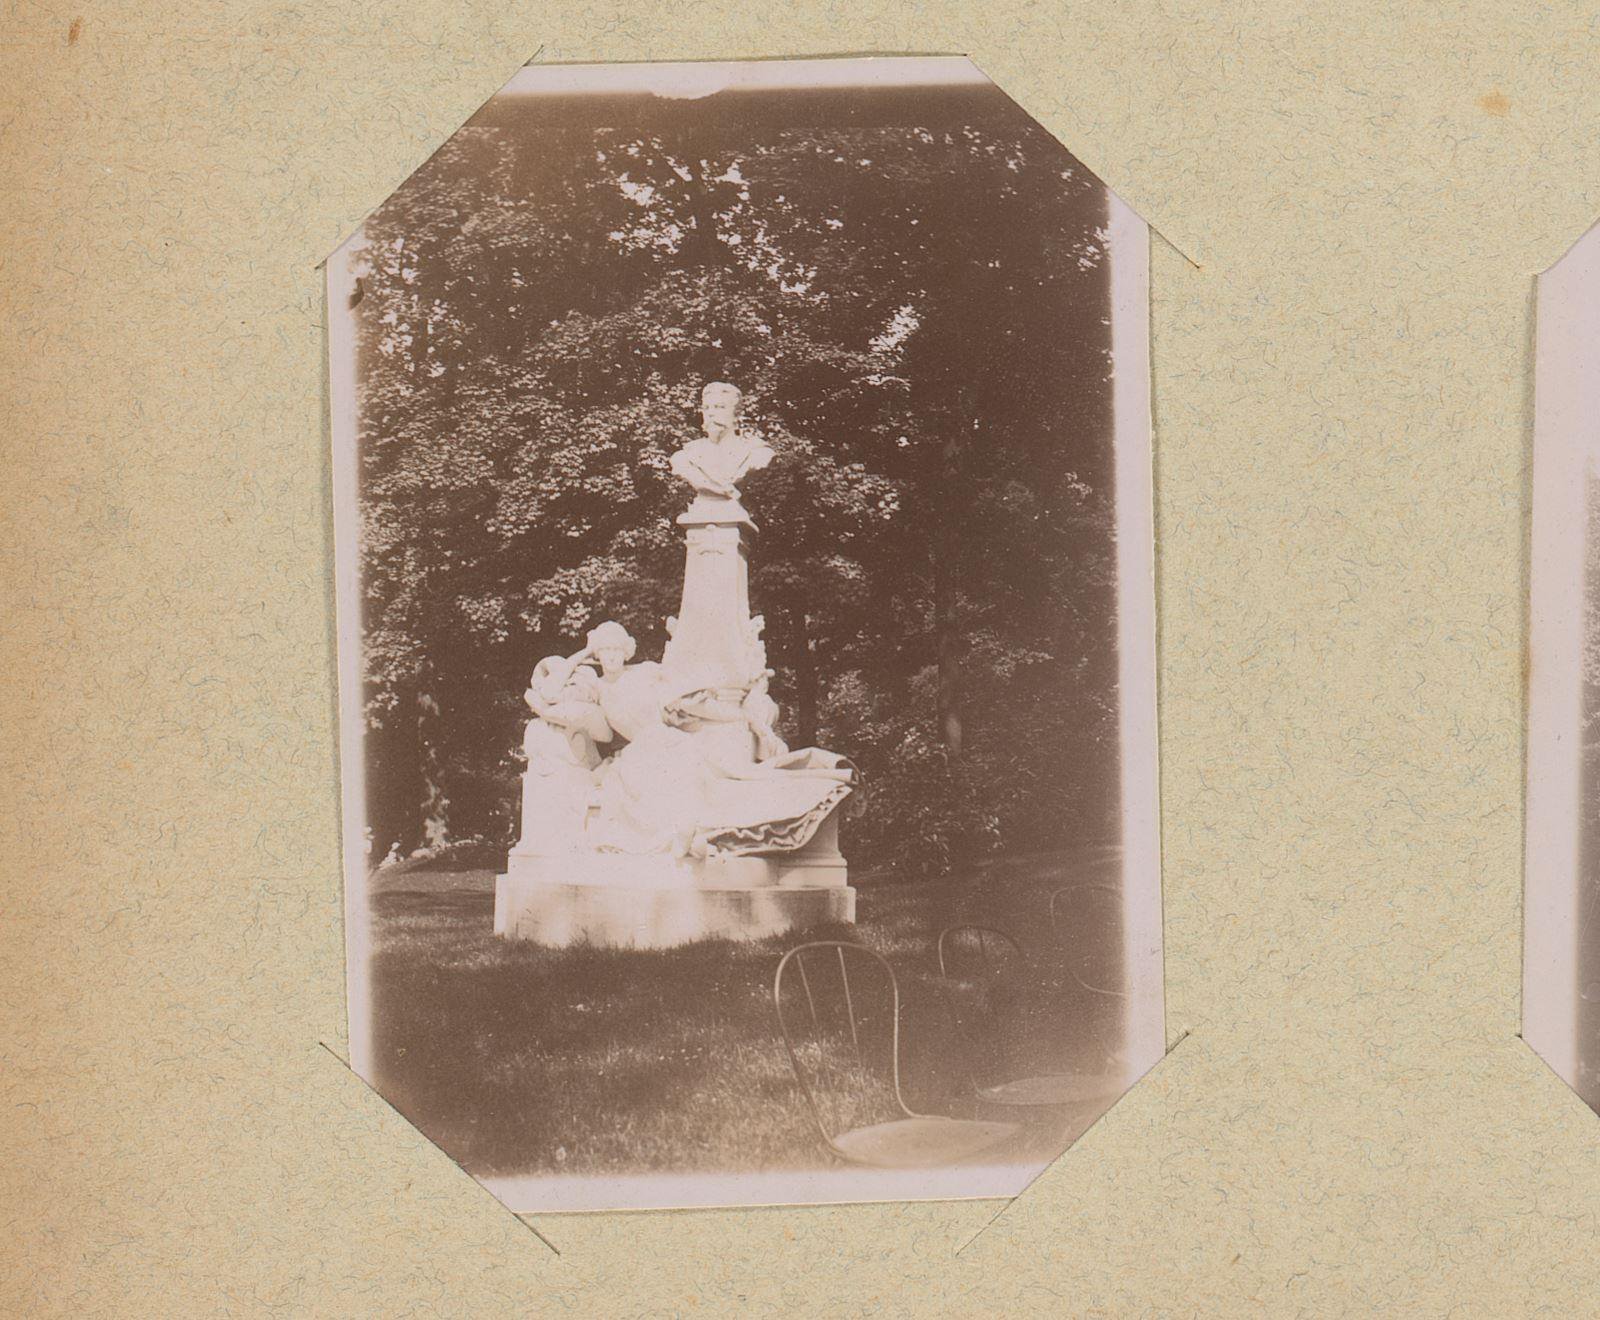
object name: photograph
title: Monument voor Guy de Maupassant in Parc Monceau, Parijs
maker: Anonymous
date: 1897-1900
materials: paper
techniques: gelatin silver print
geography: parc monceau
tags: paris, monument, statue